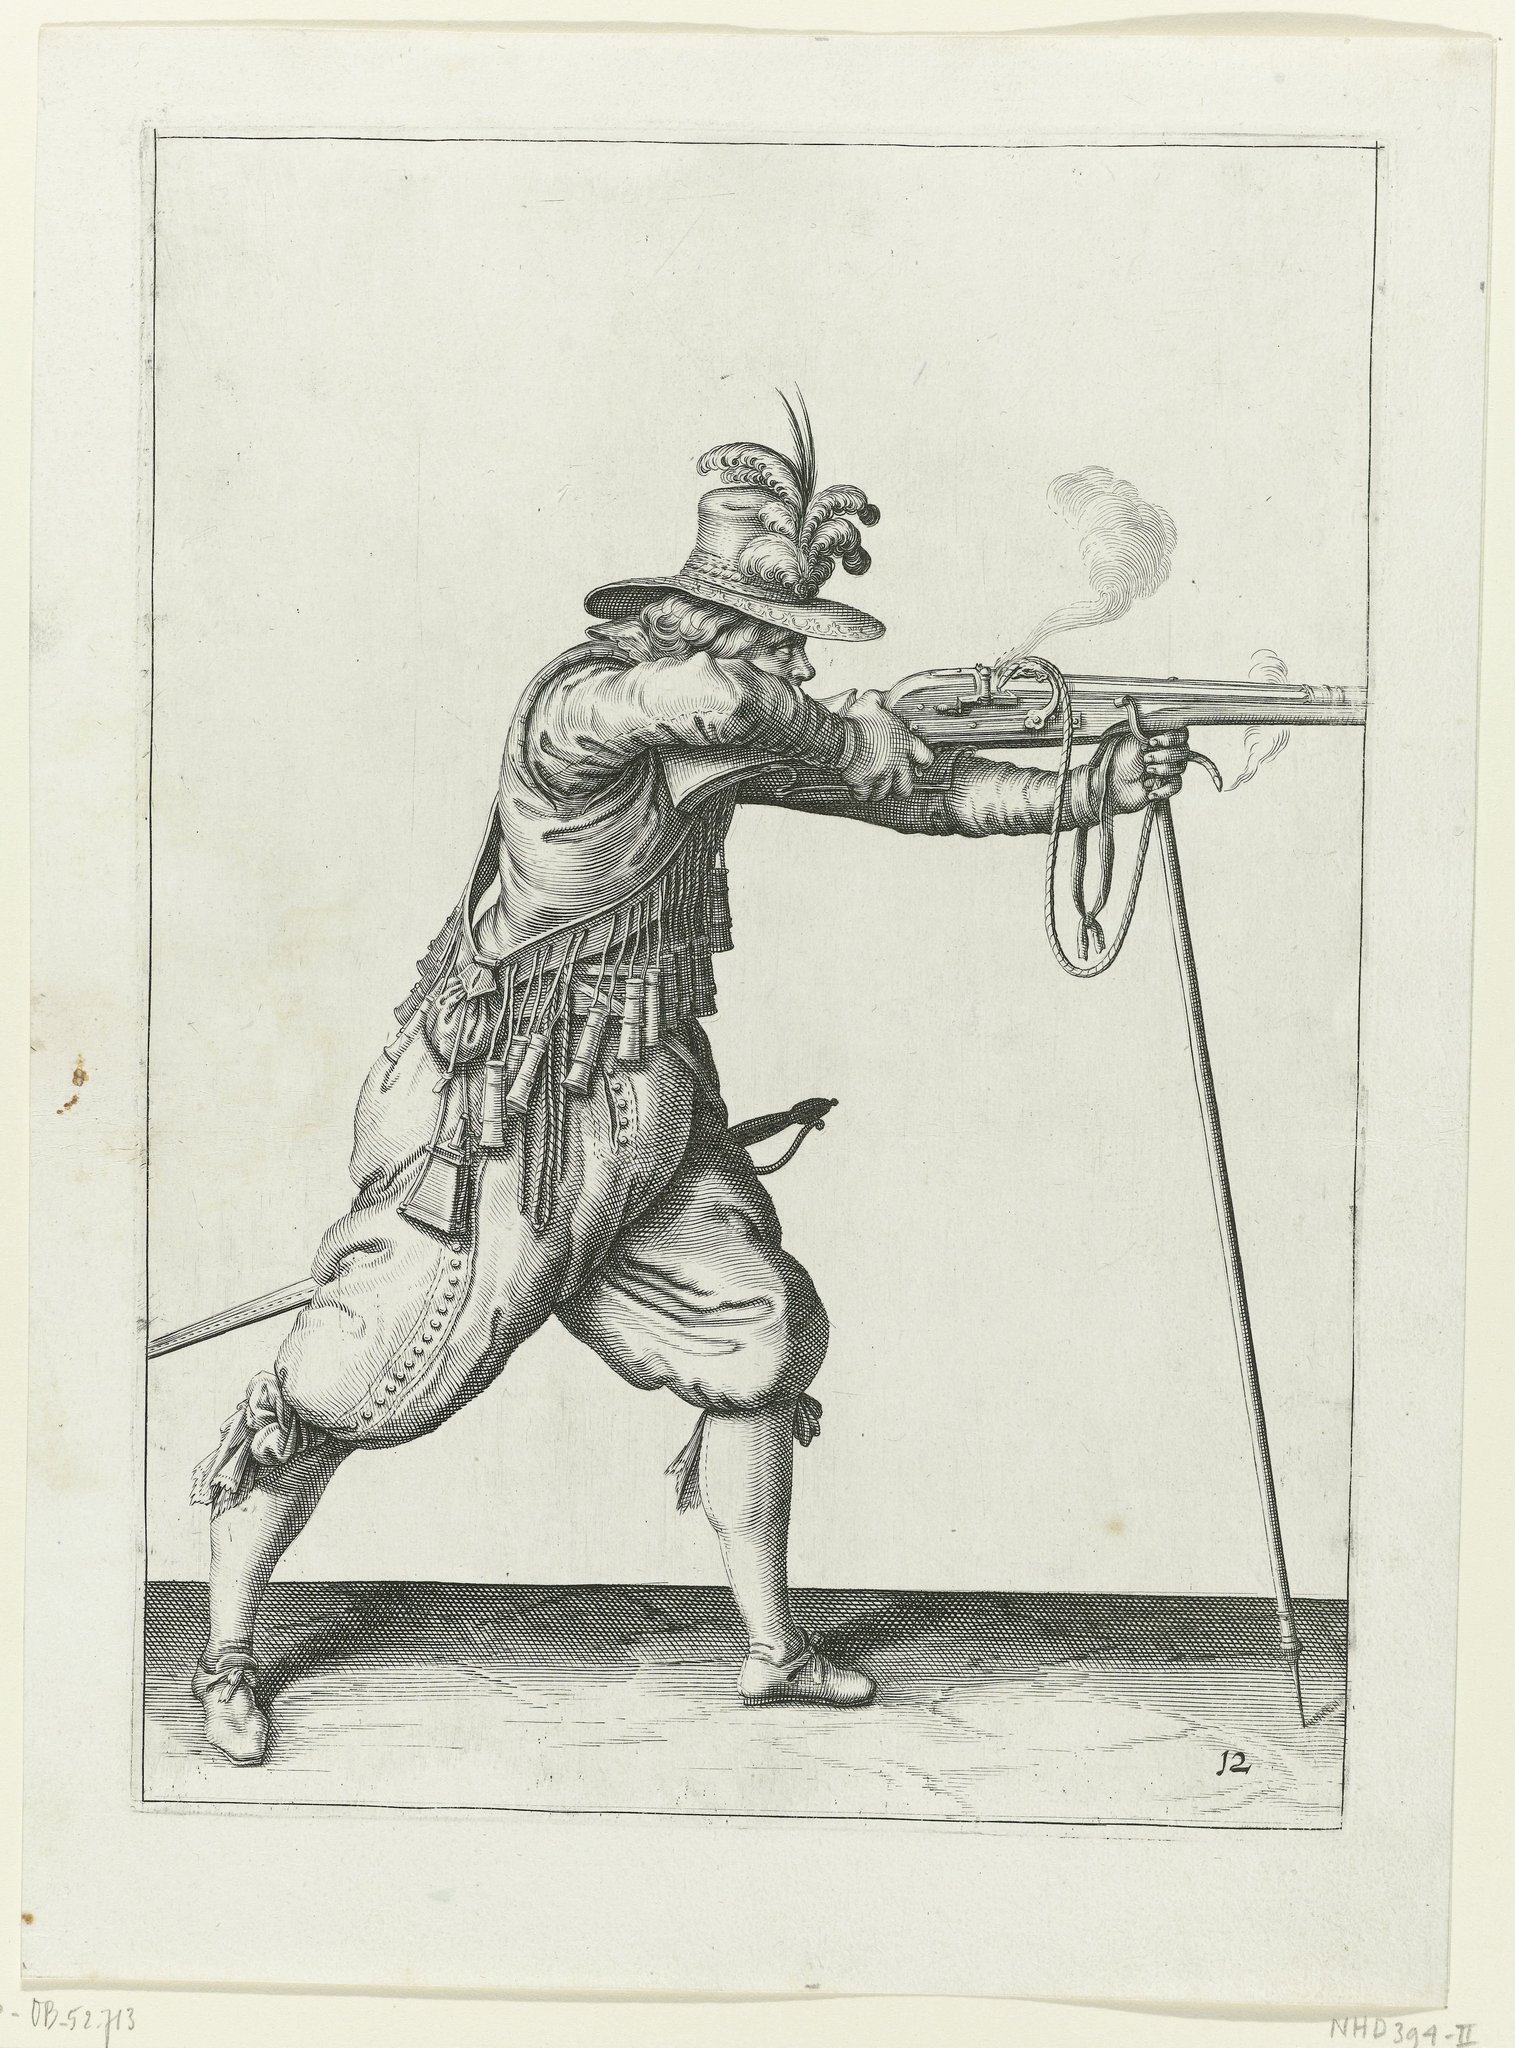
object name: print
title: Soldaat die zijn musket, steunend op zijn furket, afvuurt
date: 1597-1607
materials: paper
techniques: engraving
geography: netherlands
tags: manoeuvre ~ military training, firearms: rifle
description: Een soldaat, ten voeten uit, naar rechts, die een musket (een bepaald type vuurwapen) met beide handen richt op een doelwit, de loop steunend op een furket (musketvork), en afvuurt. Deze prent is onderdeel van de reeks van 43 genummerde prenten van musketiers uit de Wapenhandelinghe.